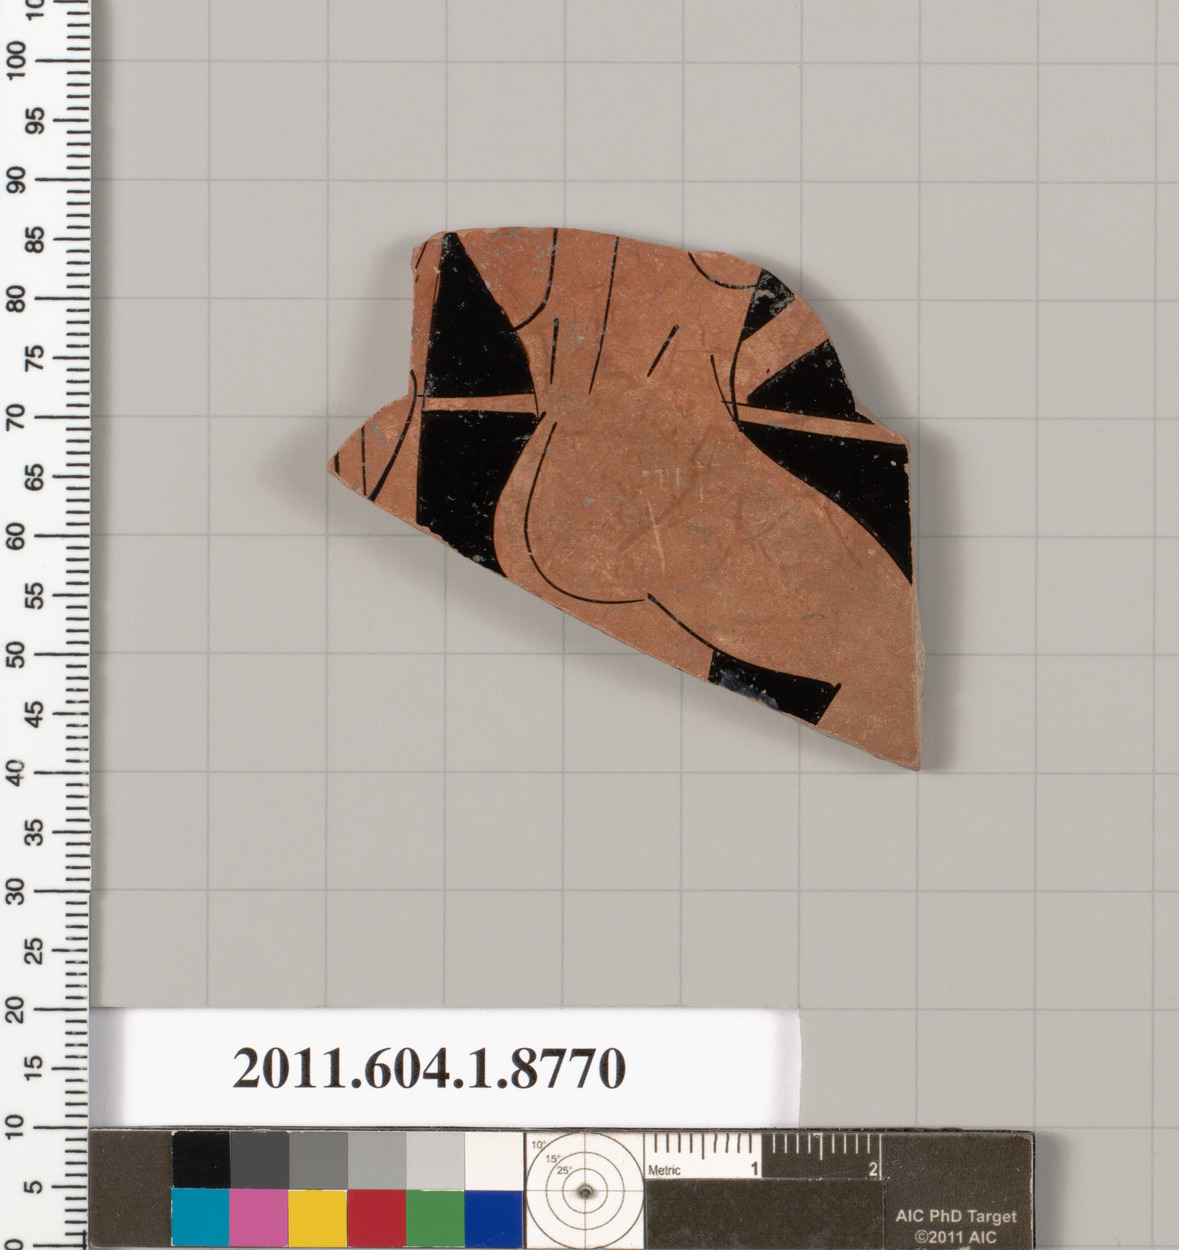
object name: kylix fragment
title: Terracotta fragment of a kylix (drinking cup)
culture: greek, attic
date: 490-480 BCE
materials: terracotta